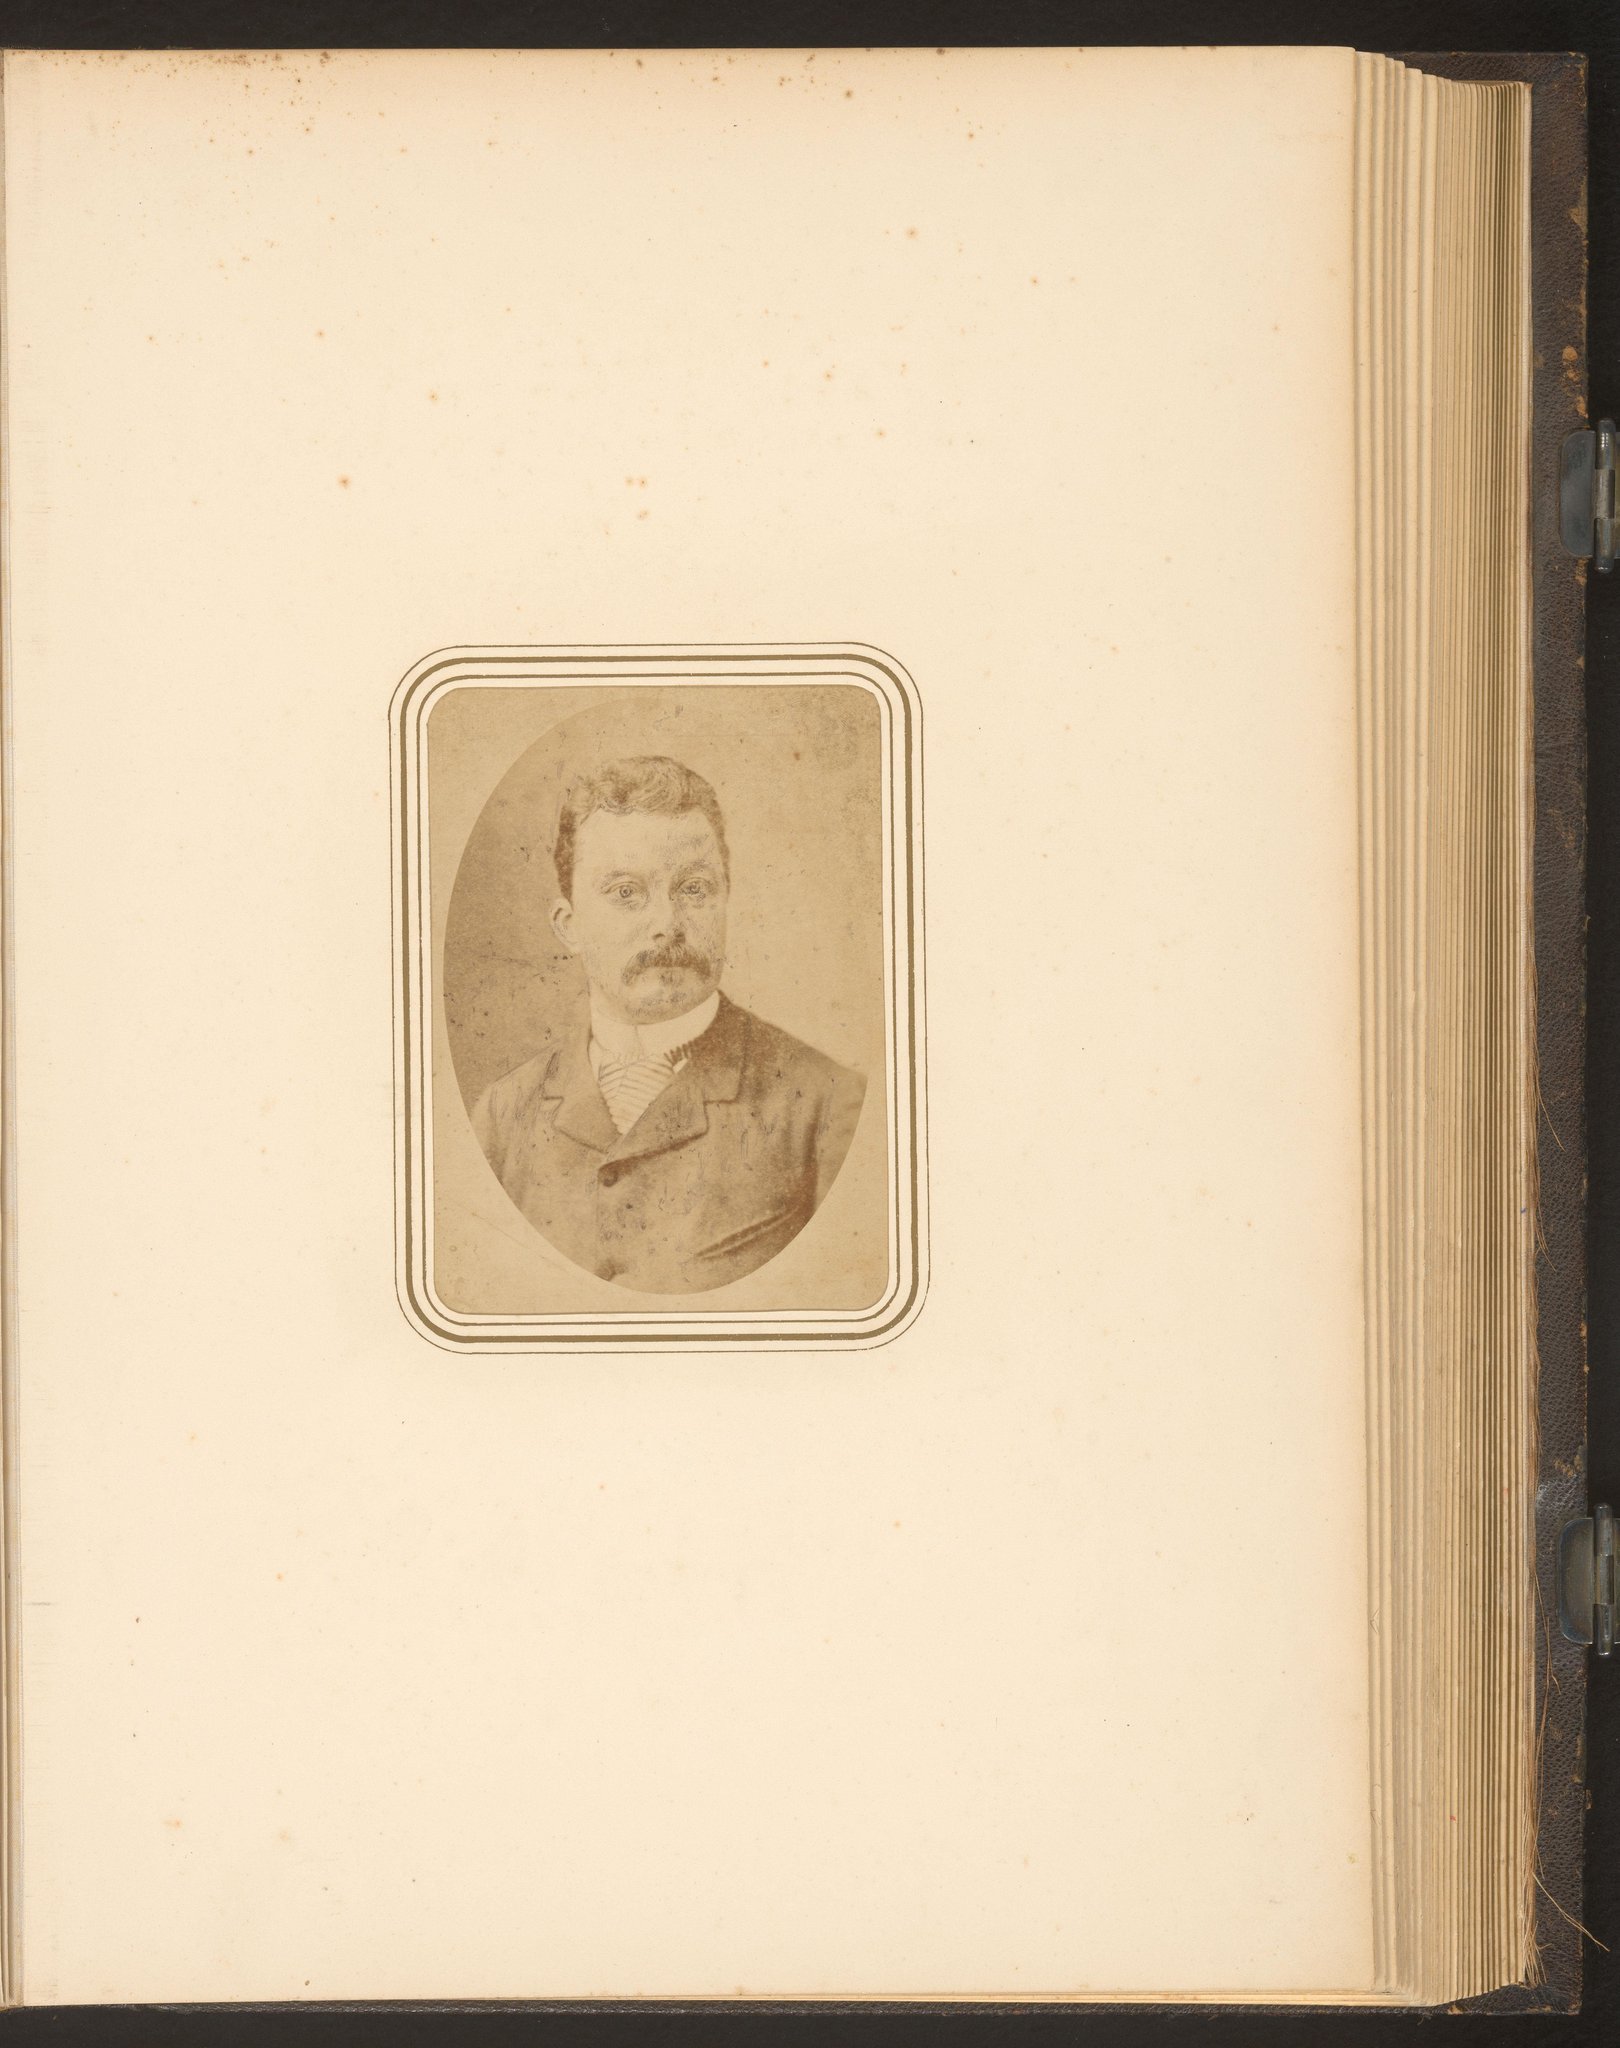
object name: cabinet photograph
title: Portret van onbekende man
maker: Anonymous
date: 1882-1887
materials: cardboard, photographic support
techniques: albumen print, retouching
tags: historical persons not known by name, sumatra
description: Portret van een onbekende man. Ingestoken foto in het herinneringsalbum aangeboden door de Tabak Maatschappij Arendsburg aan hoofdadministrateur M.J. Tiele bij zijn terugkeer naar Nederland in 1887.